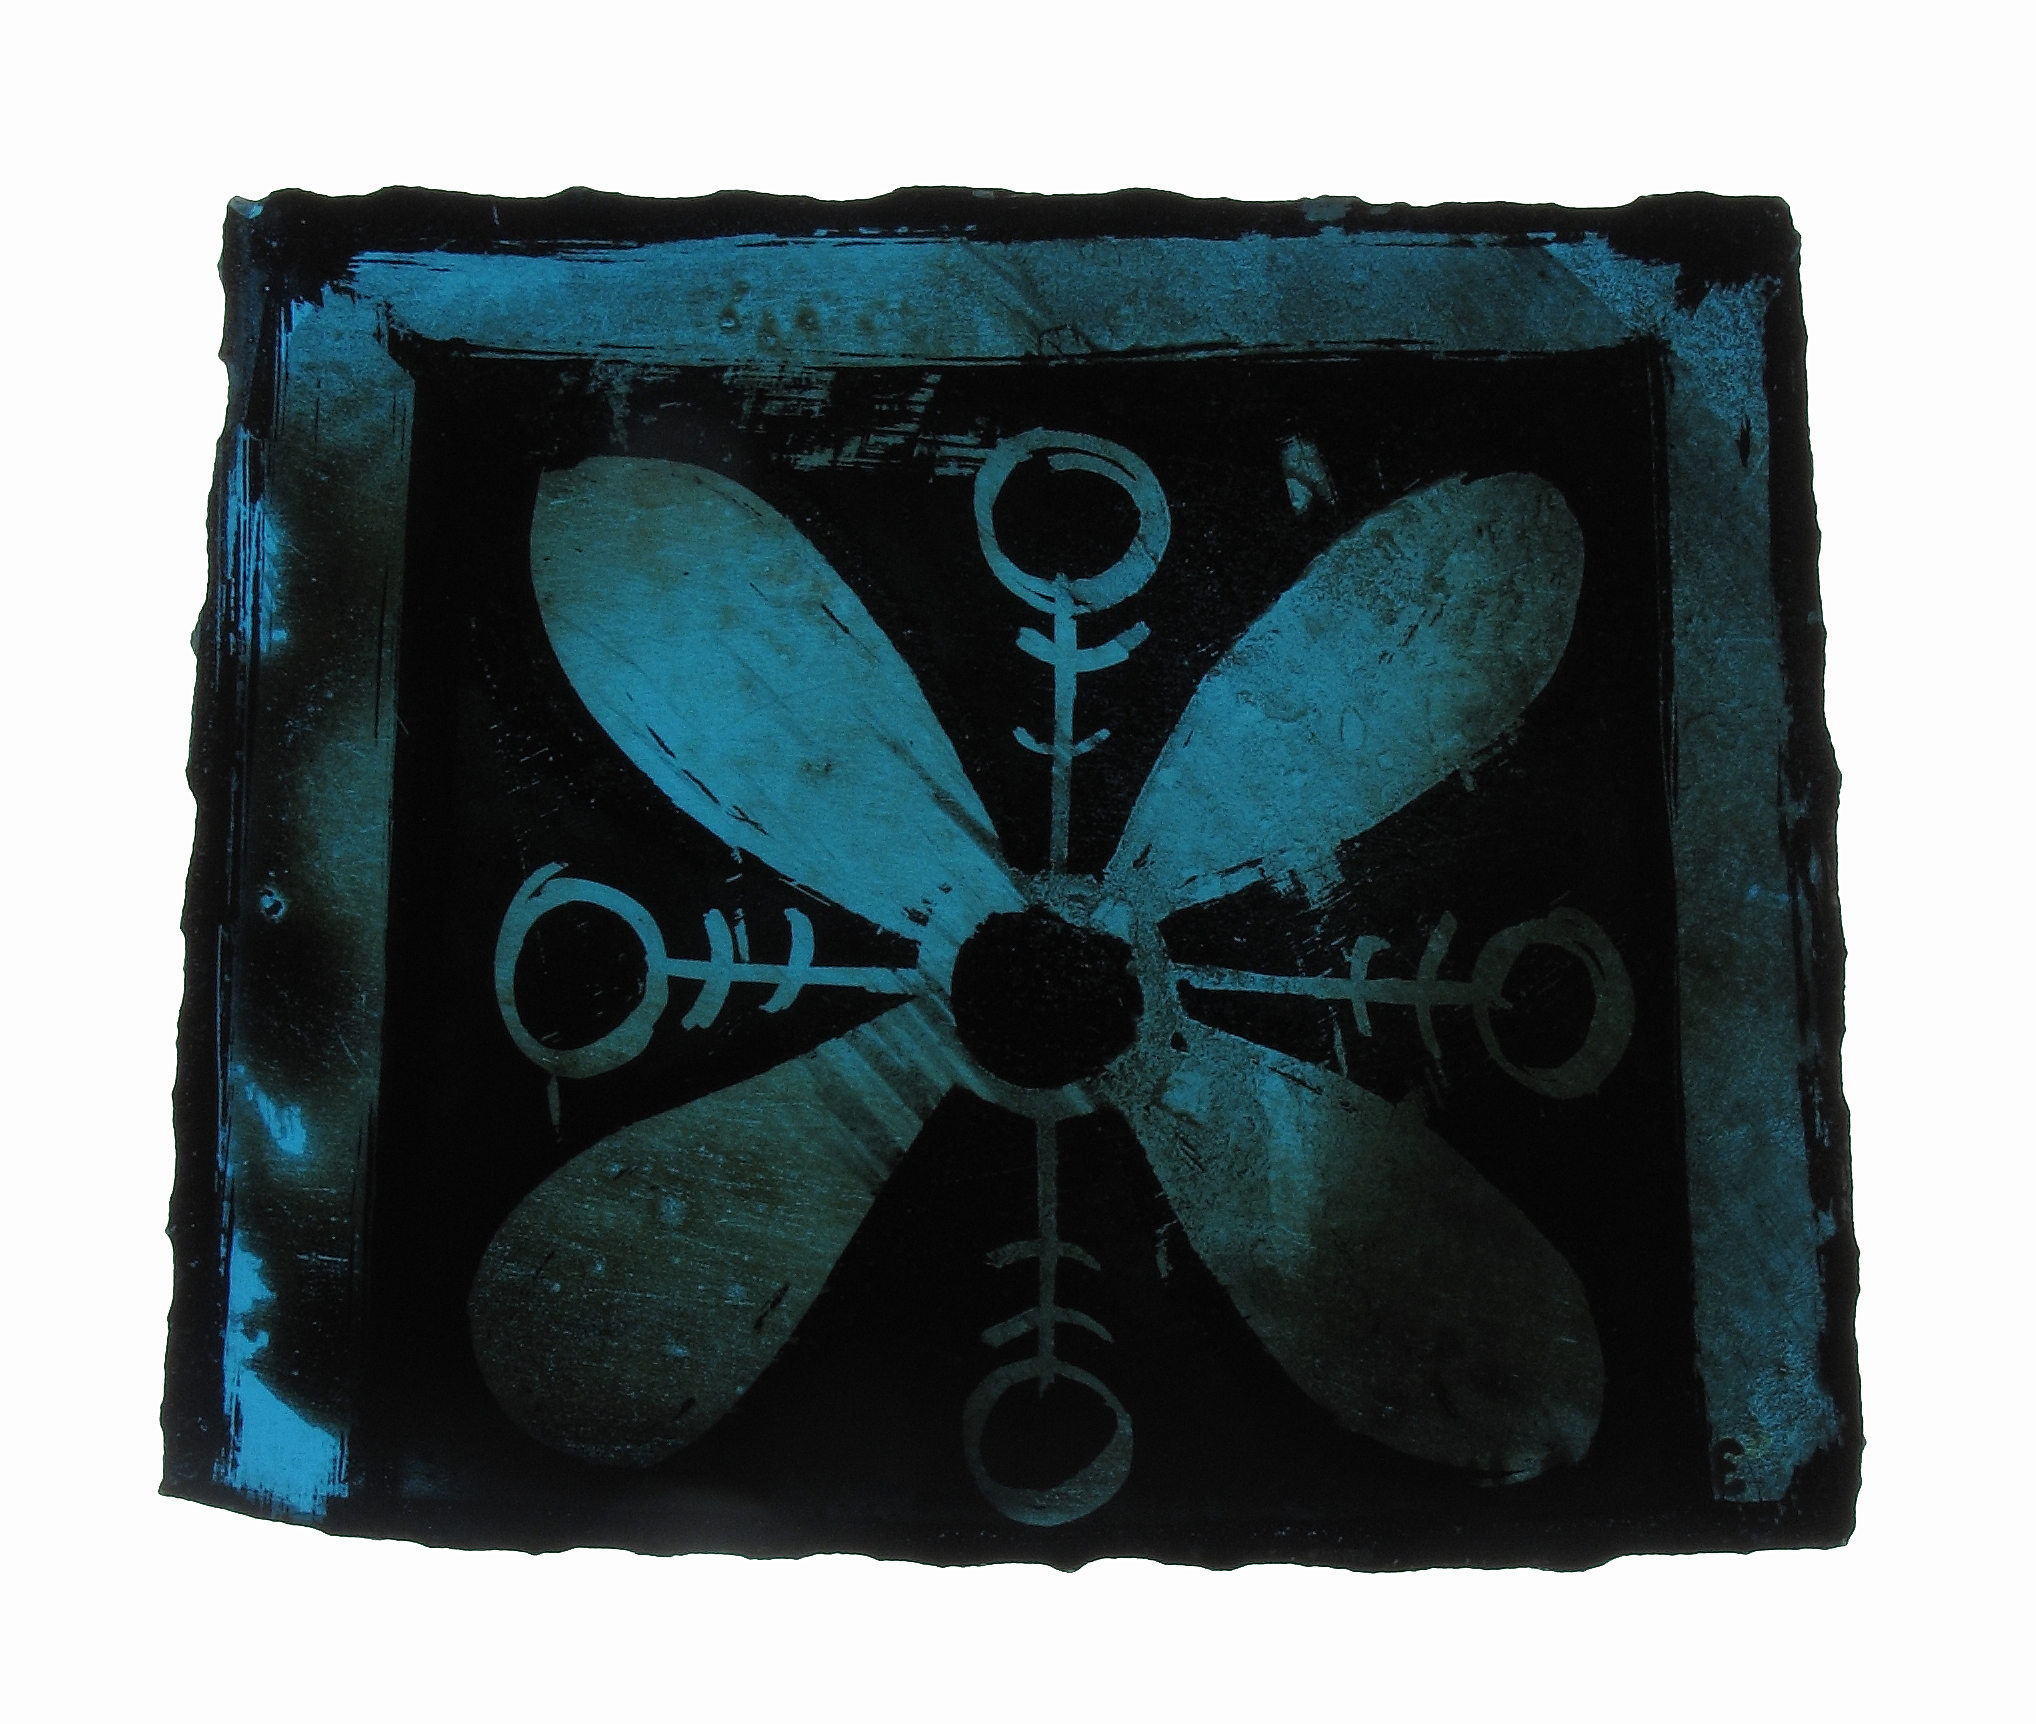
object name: fragment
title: Glass Fragment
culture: european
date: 1301-1400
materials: glass, metal